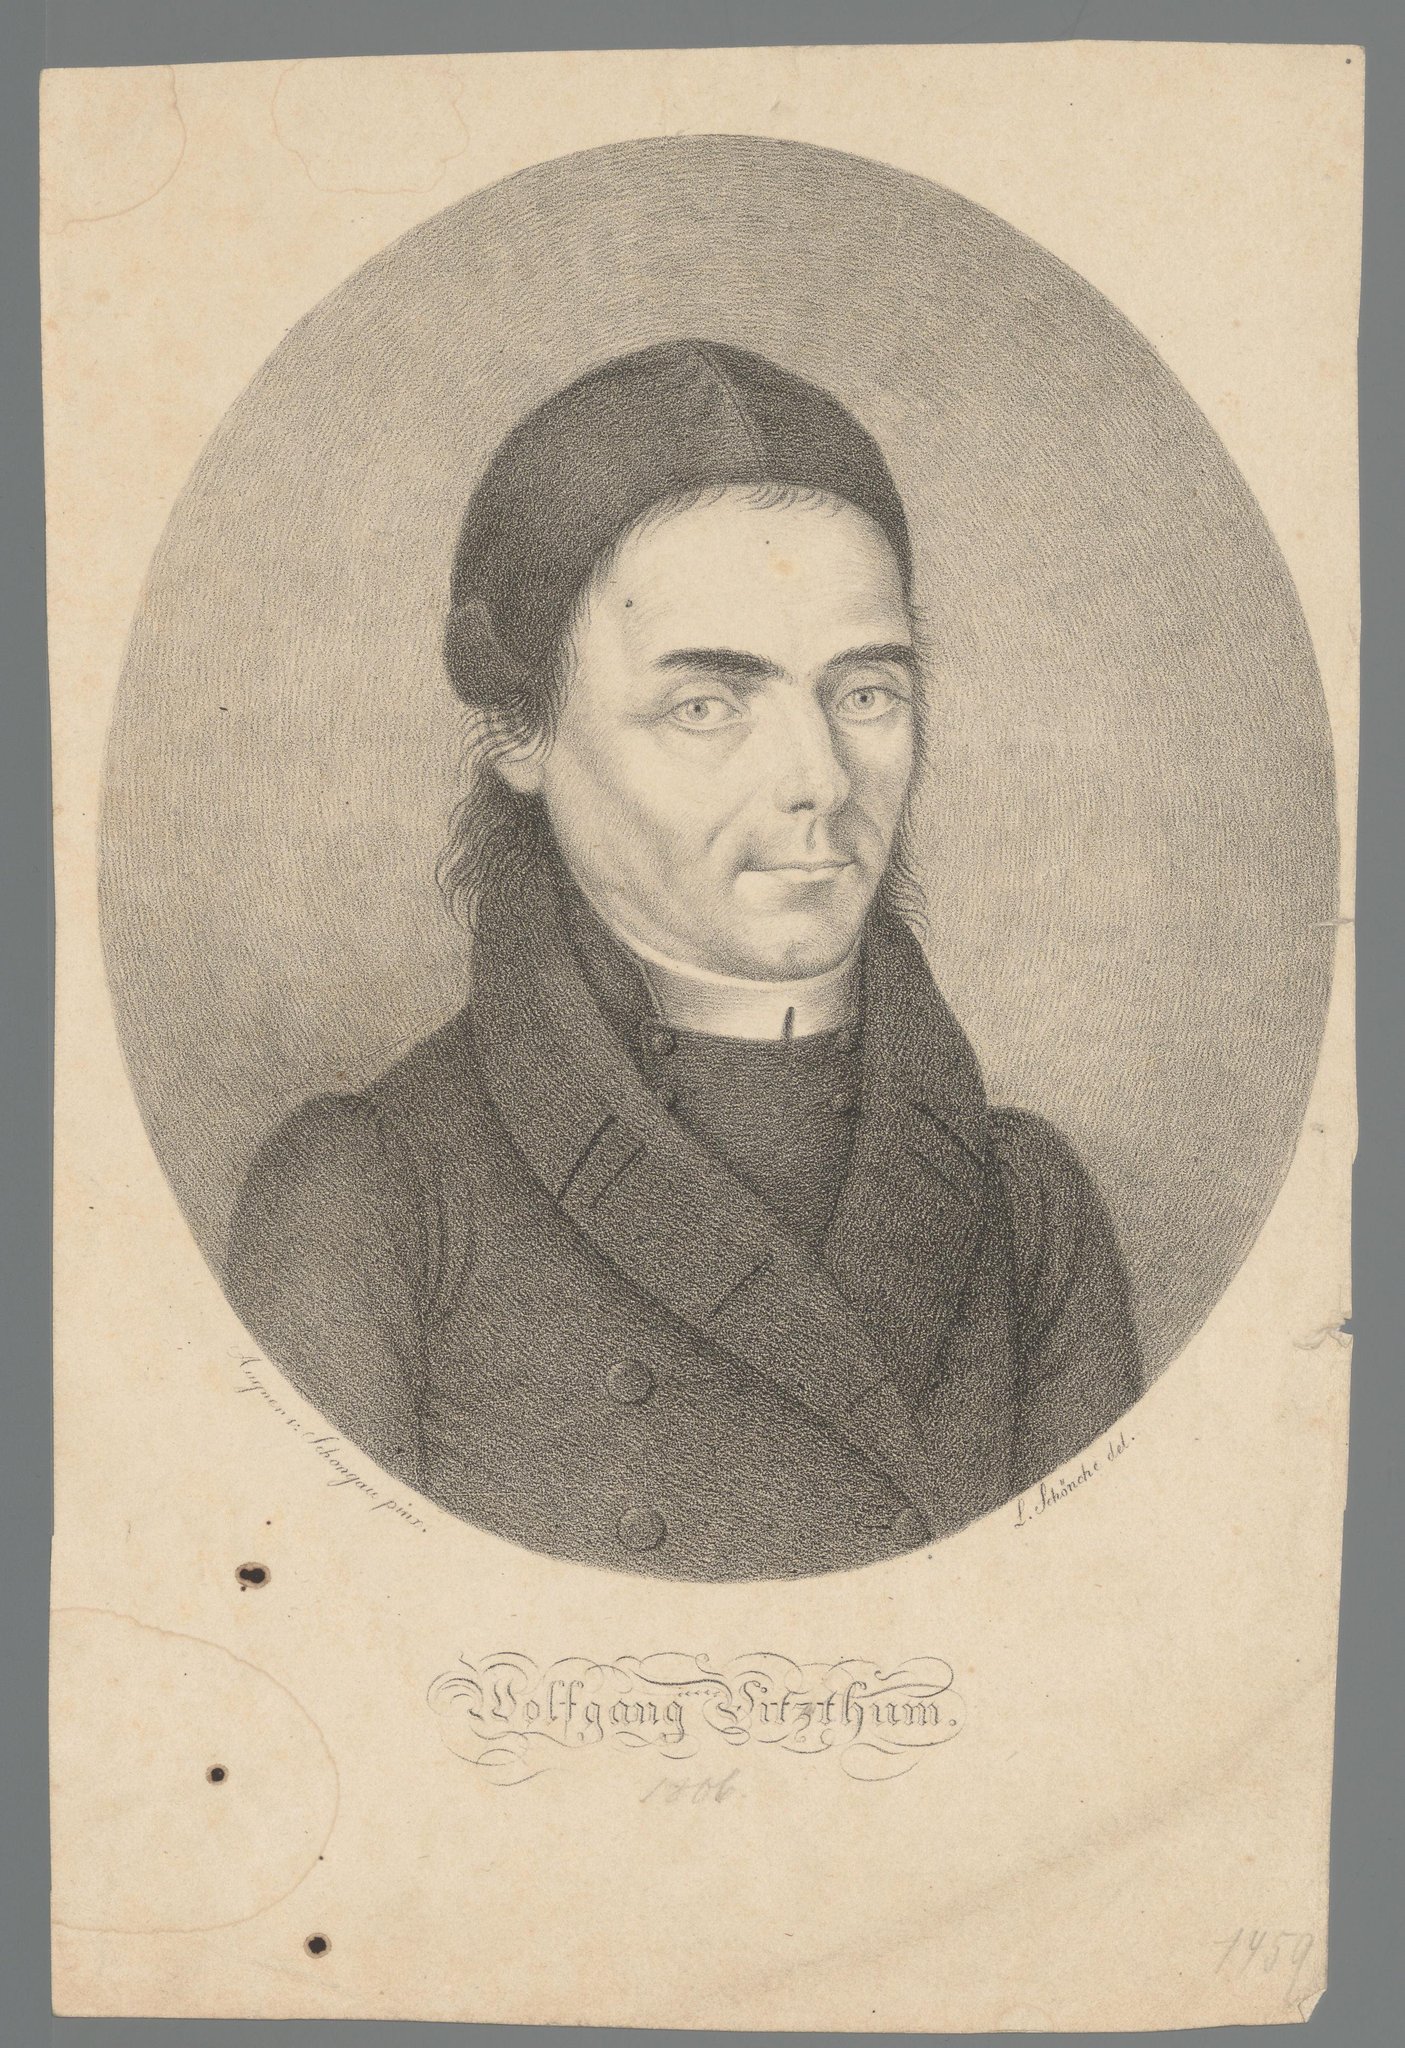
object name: print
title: Portret van Wolffgang Vitzthum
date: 1810-1860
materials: paper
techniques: lithograph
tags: historical persons not known by name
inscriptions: collector's mark: Lugt 2228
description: Portret van een verder onbekende man met de naam Wolffgang Vitzthum.